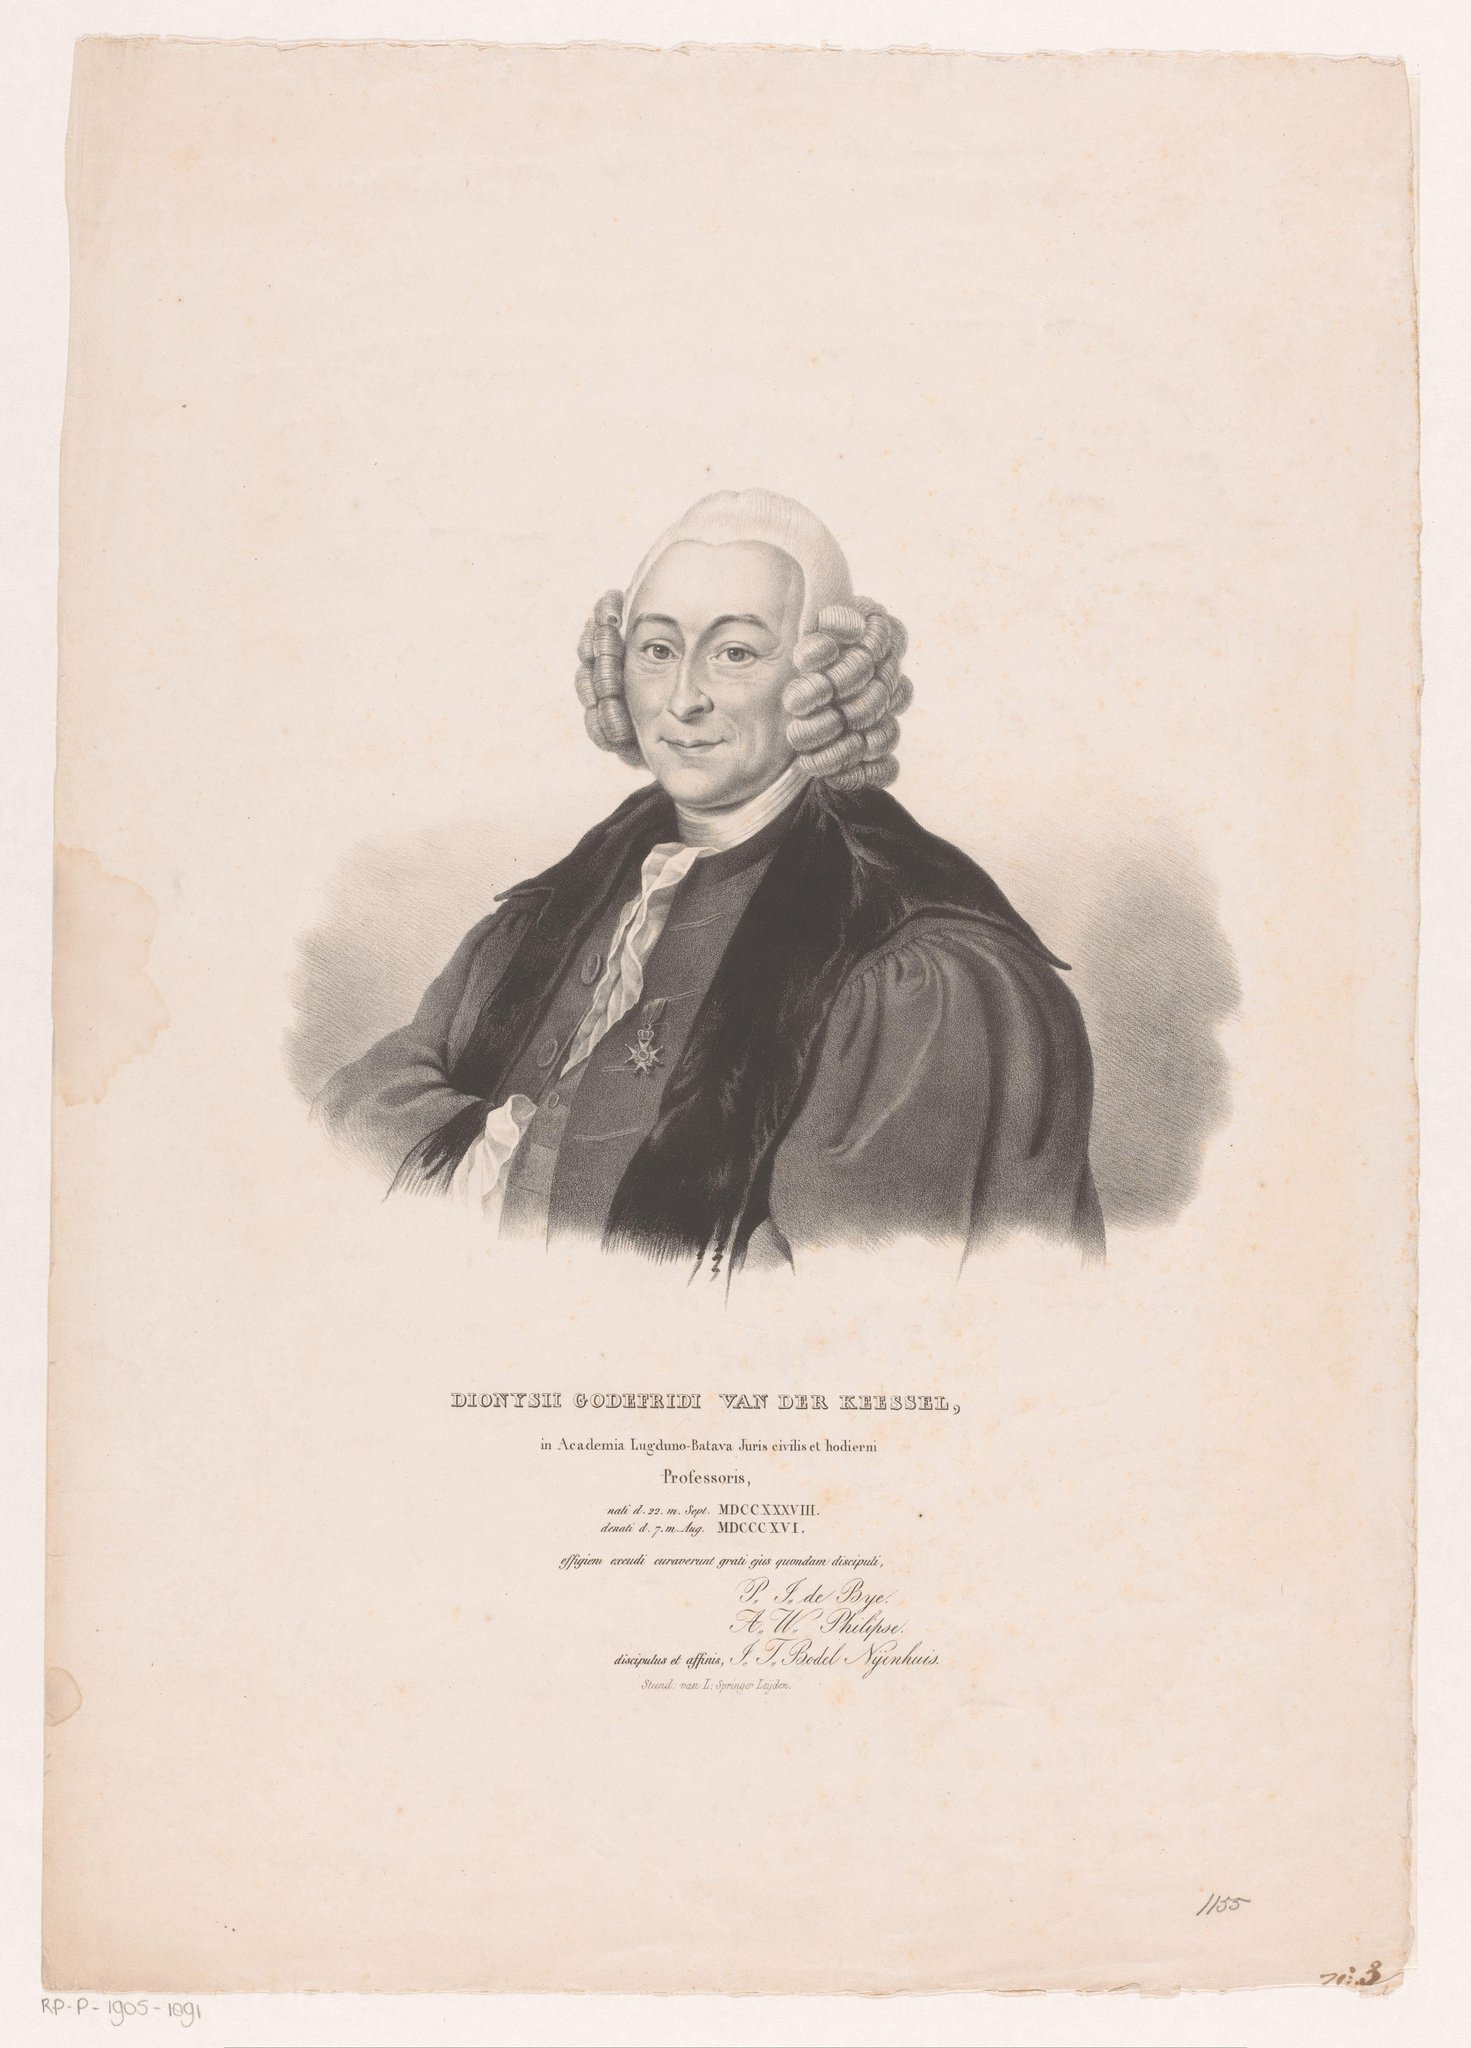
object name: print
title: Portret van Dionysius Godefridus van der Keessel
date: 1828-1836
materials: paper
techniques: lithograph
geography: leiden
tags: deventer, historical persons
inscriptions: collector's mark: Lugt 2228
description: Onder het portret de biografische gegevens van de geportretteerde en de namen van drie van zijn leerlingen die dit portret na zijn dood lieten maken.